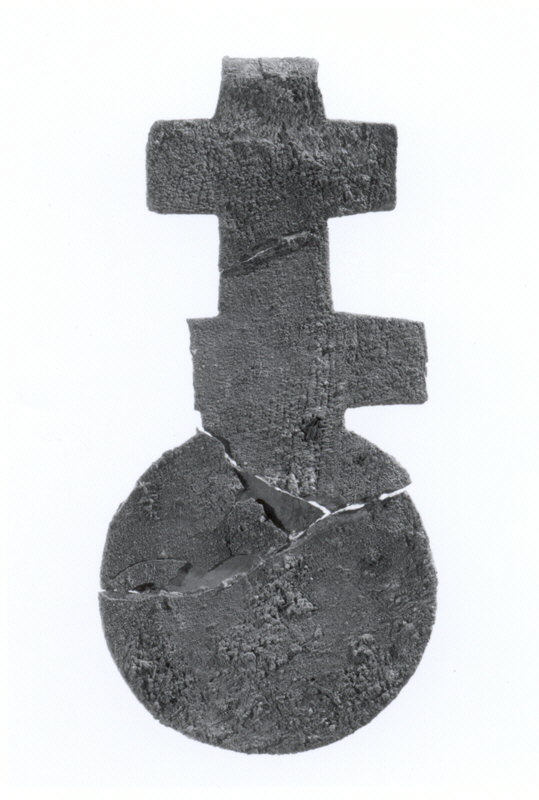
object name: harness or bridle fitting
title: Harness or bridle ornament or fitting (?)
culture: iranian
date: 900-801 BCE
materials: bronze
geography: iran